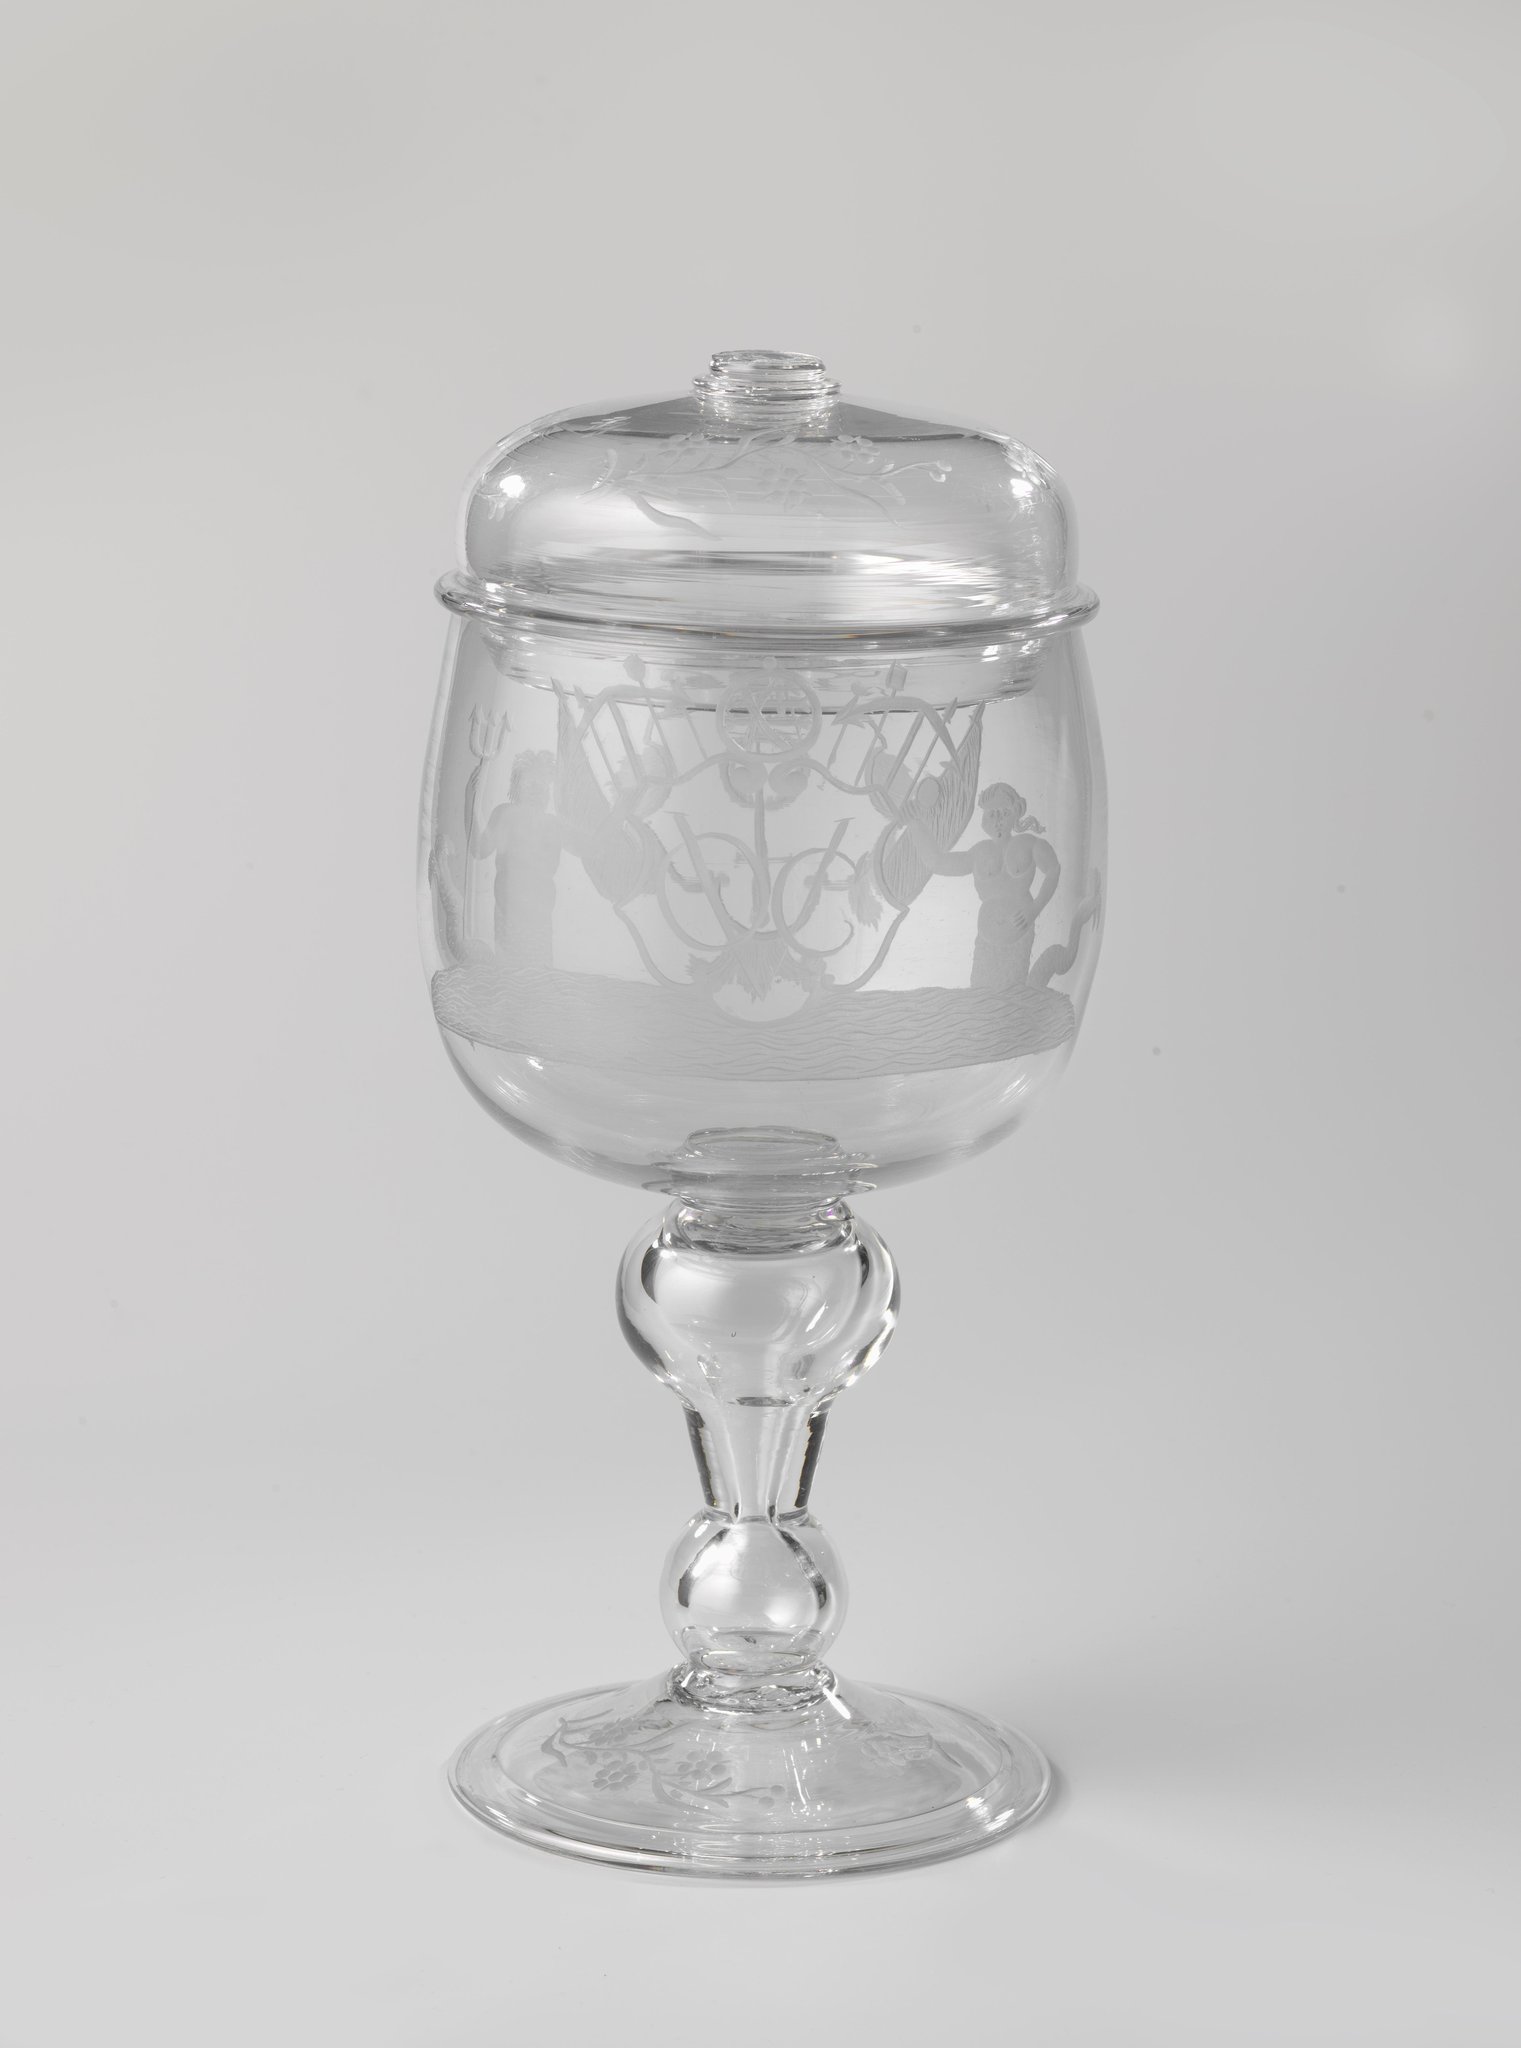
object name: lid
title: Deksel van bokaal, met het wapen van Batavia en het VOC-monogram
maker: Anonymous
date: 1700-1725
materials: glass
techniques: glassblowing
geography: northern netherlands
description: Voet en deksel met bladornament. De dekselknop ontbreekt.